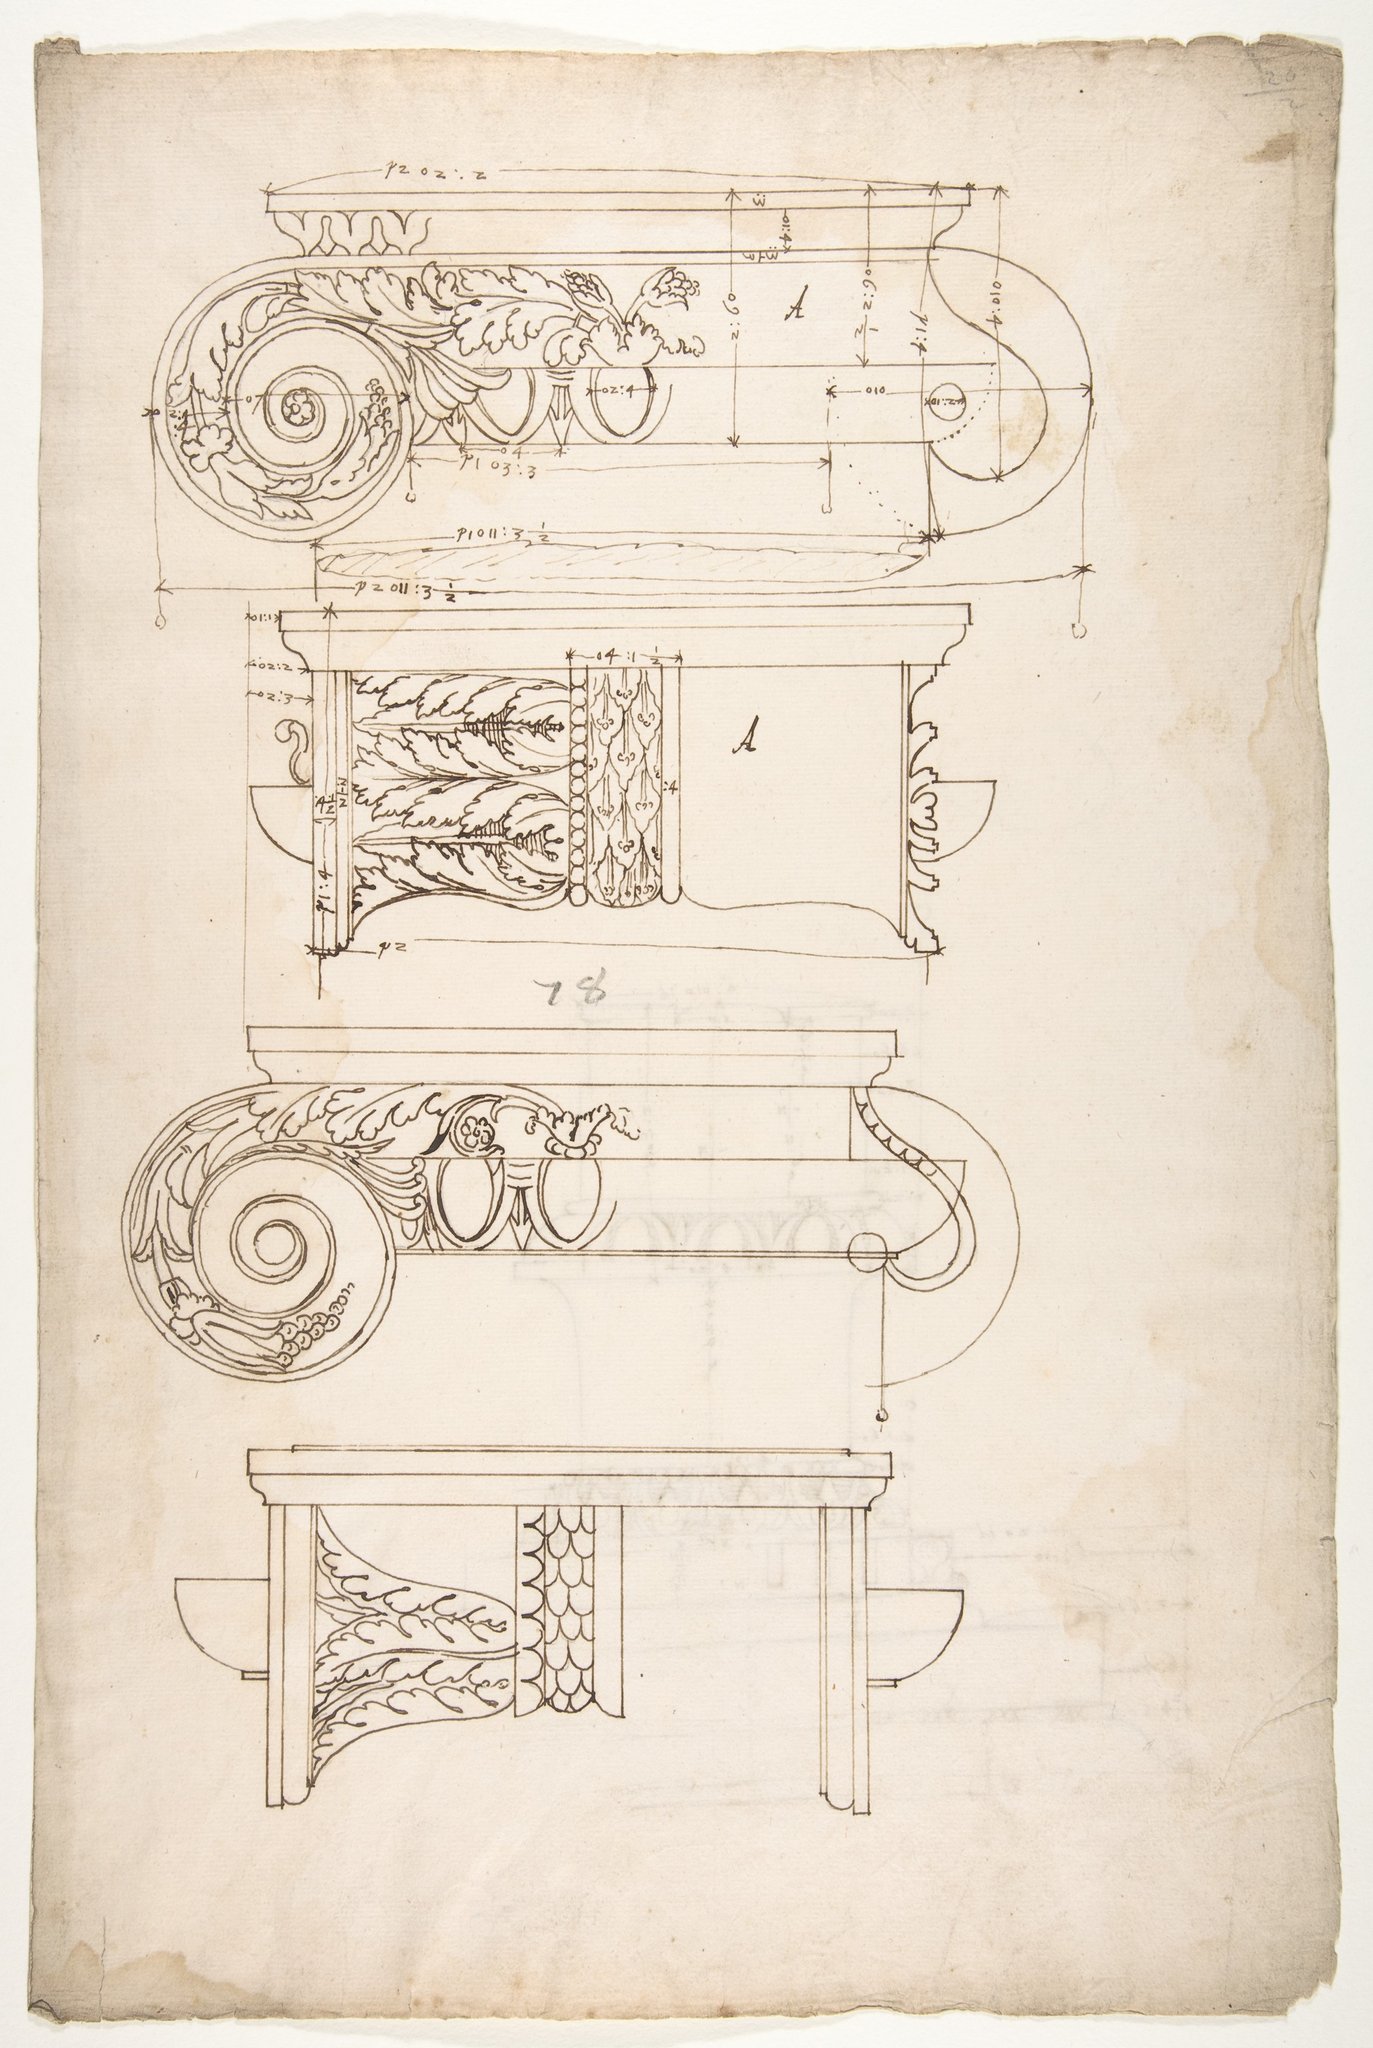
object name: collection ornament architecture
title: Unidentified, Ionic capitals, two front and side elevations (recto) Doric impost, elevation of entablature (verso)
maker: anonymous, french, 16th century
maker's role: draftsman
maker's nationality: french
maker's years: 1500-1600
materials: chalk, ink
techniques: incising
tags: capitals